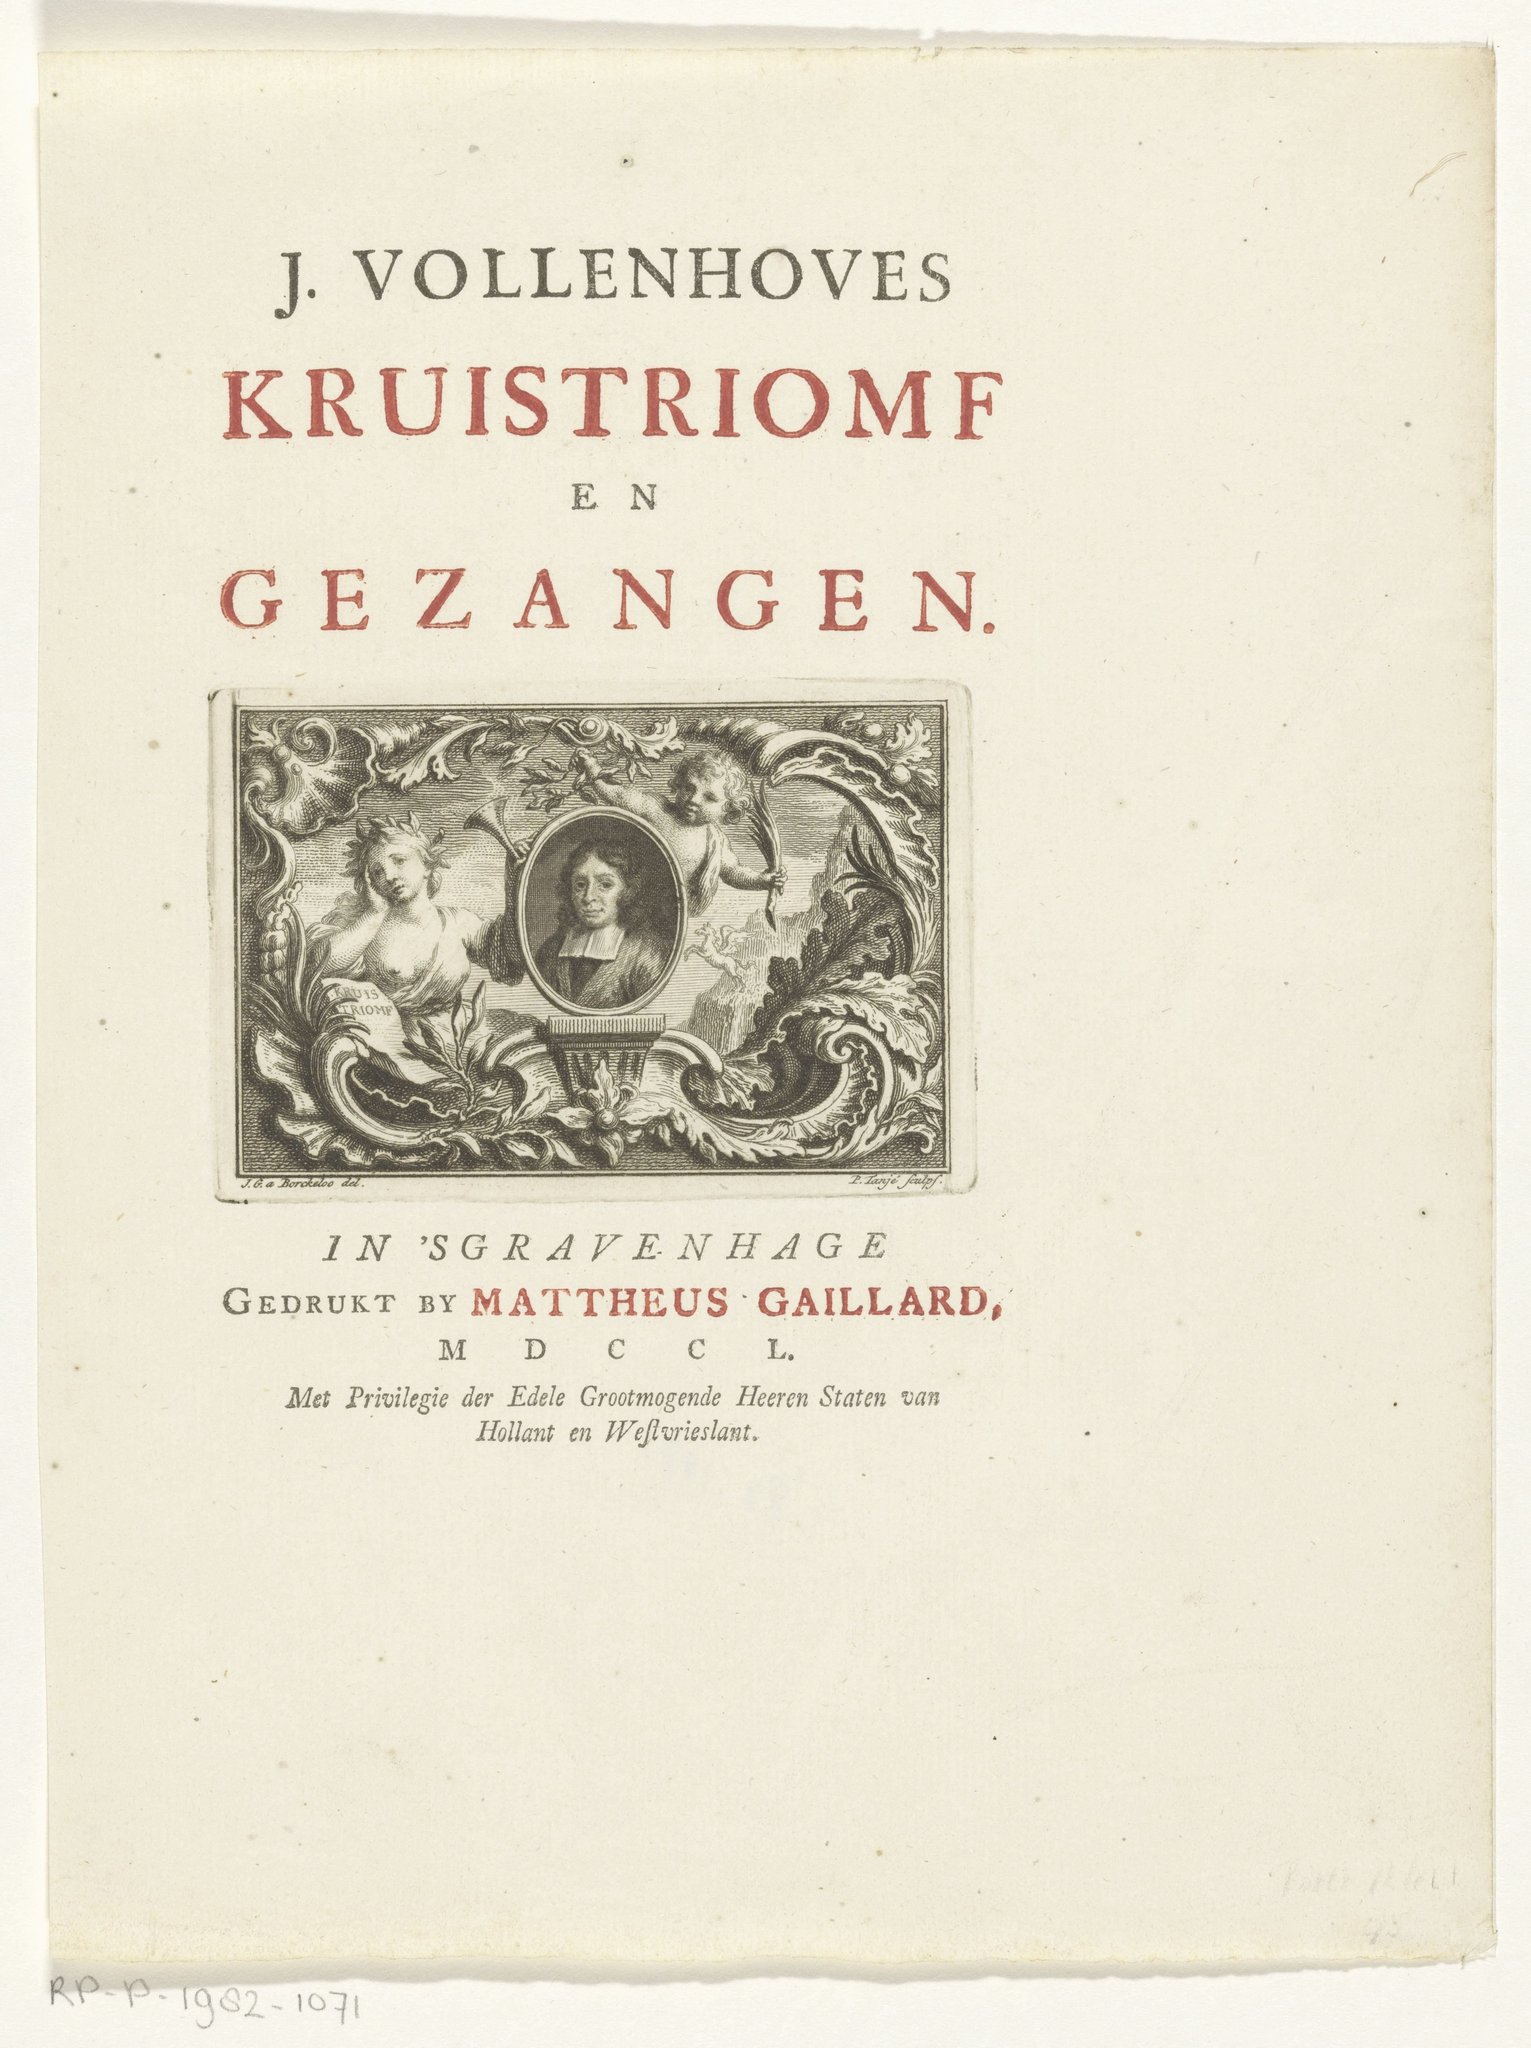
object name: titelblad, titelpagina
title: Titelpagina voor: Joannes Vollenhove, Kruistriomf en Gezangen, 1750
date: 1750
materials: paper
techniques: engraving, etching, letterpress printing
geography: the hague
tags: the hague, pegasus, the winged horse, crowning with laurel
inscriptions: collector's mark: Lugt 2228, collector's mark: Lugt 2760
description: Het portret van Joannes Vollenhove, predikant te Den Haag en schrijver, wordt gekroond met een lauwerkrans door een putto. Op de achtergrond Pegasus bij de bron van poëtische inspiratie.